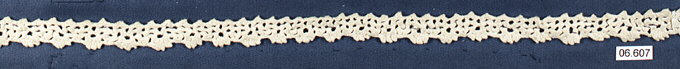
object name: edging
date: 1501-1600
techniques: lace